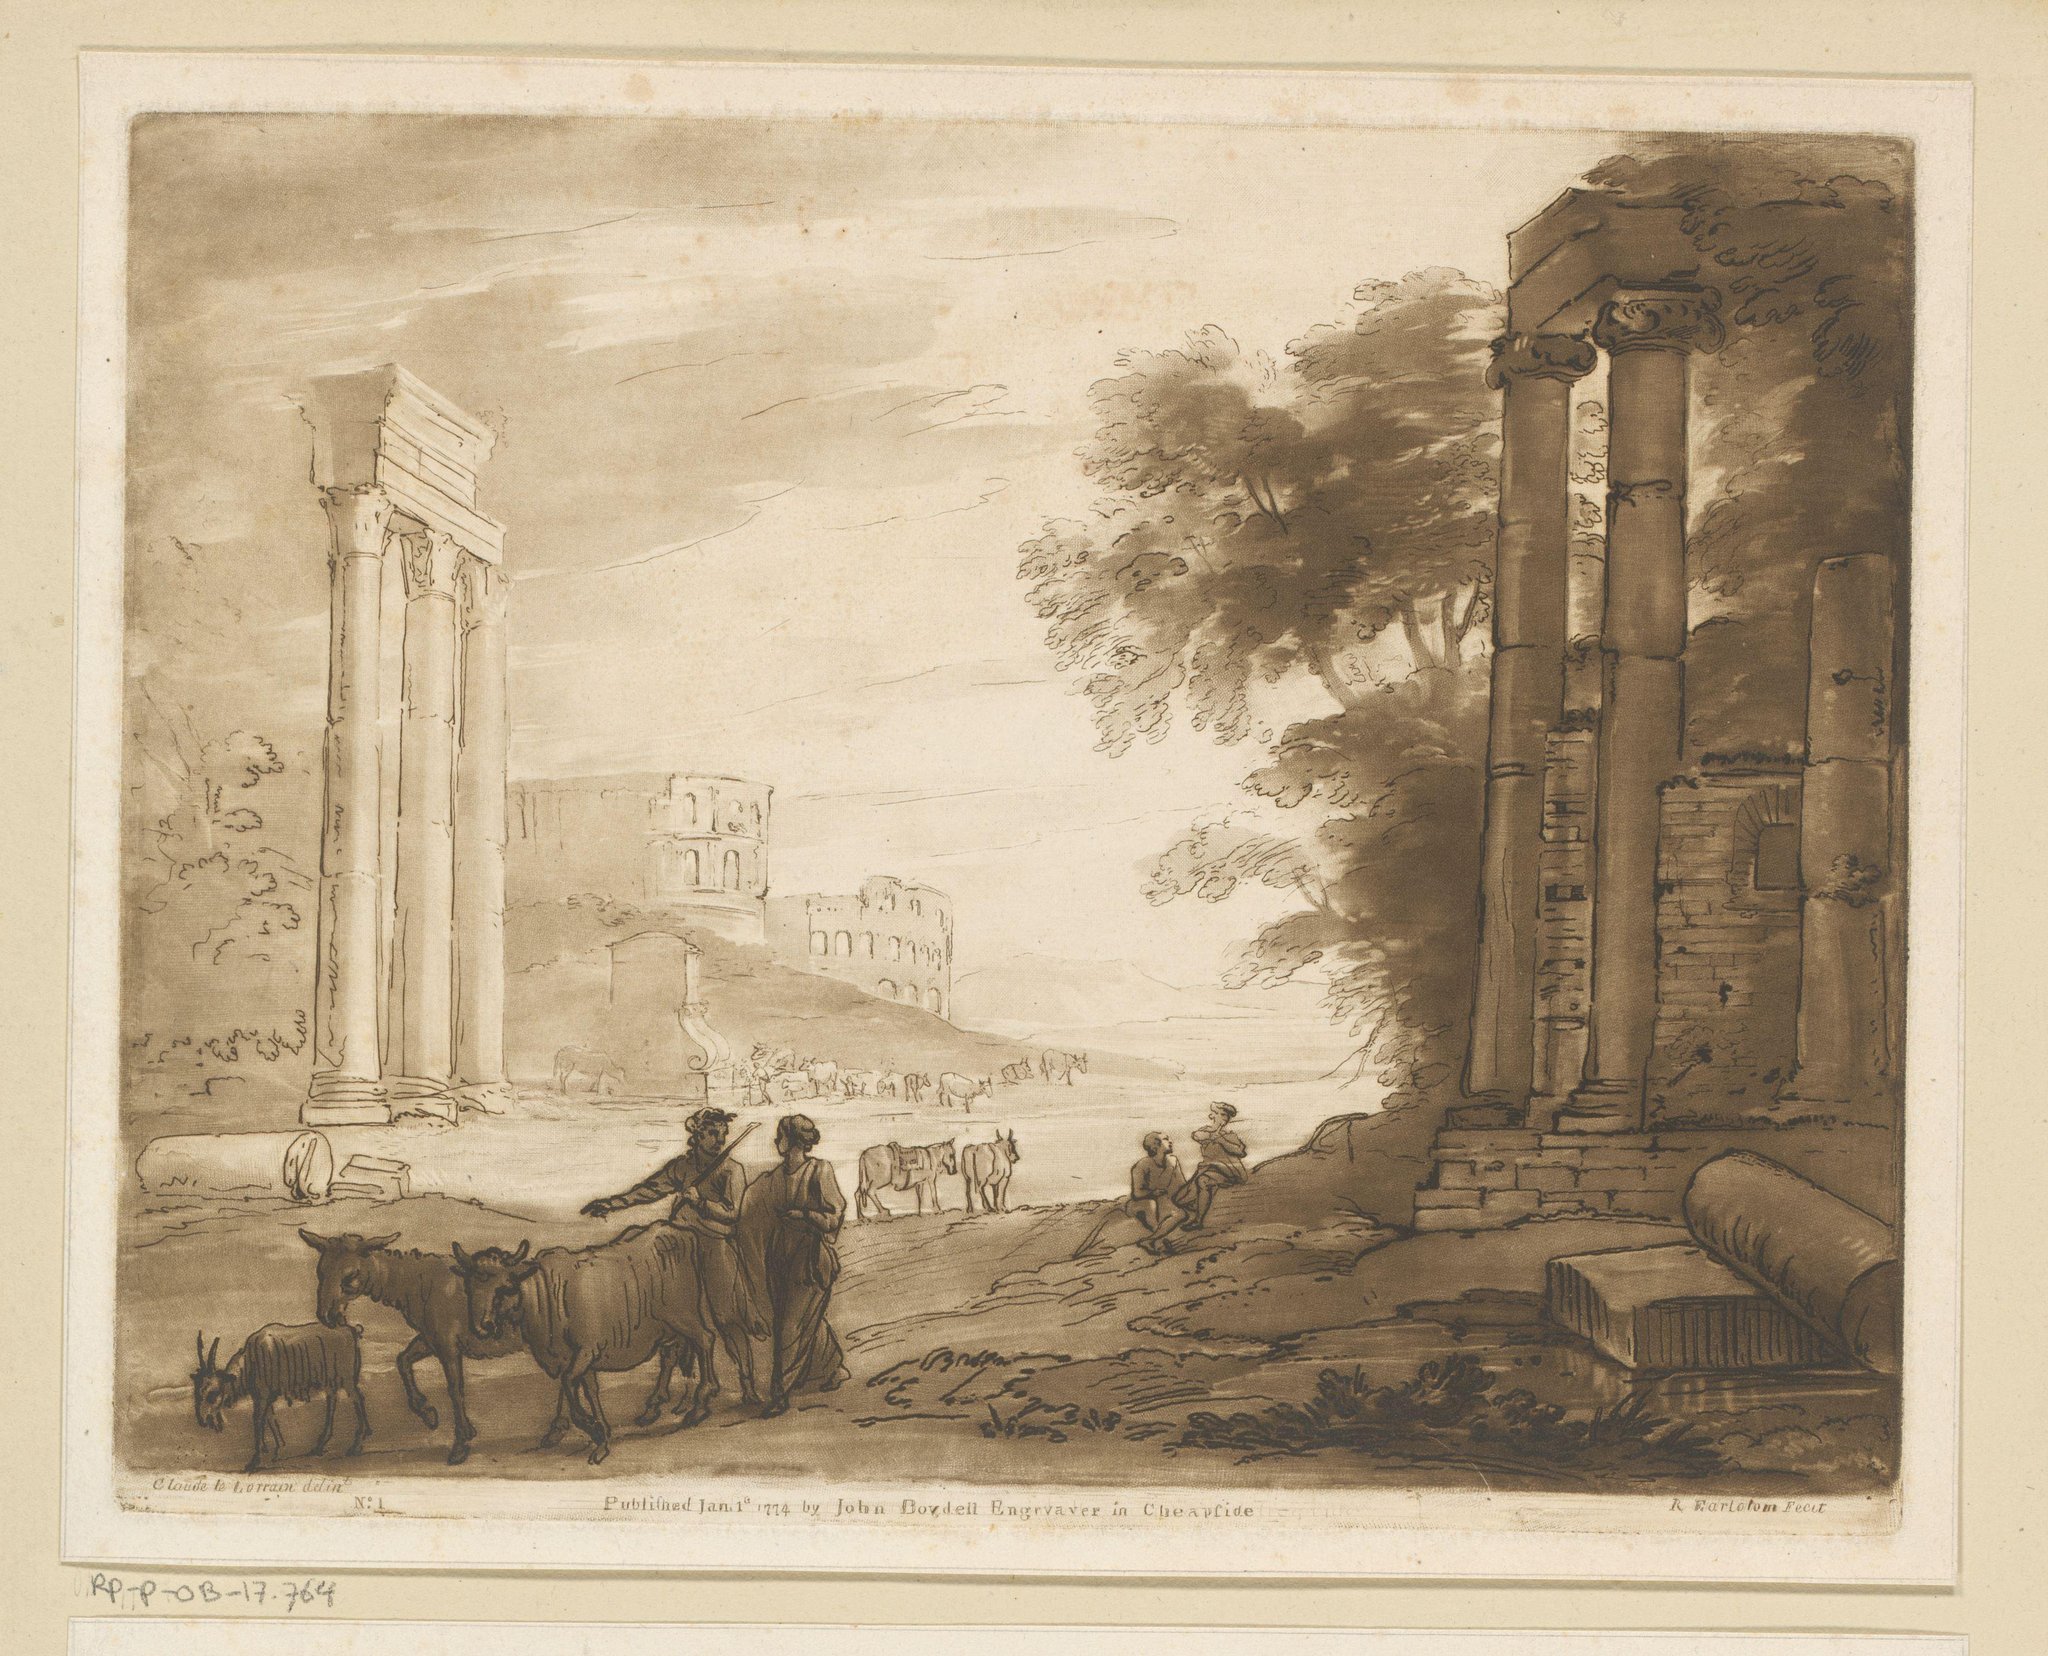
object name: print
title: Prenten naar tekeningen van Claude Lorrain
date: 1701-1774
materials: paper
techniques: etching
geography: london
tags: landscape with ruins, temple, shrine ~ roman religion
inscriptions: date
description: Vanaf 1774 publiceerde John Boydell tweehonderd prenten naar het tekeningenboek Liber Veritatis van Claude Lorrain, in het bezit van de hertogen van Cavendish. Deze werden vanaf 1777 in twee volumes gebundeld uitgegeven.